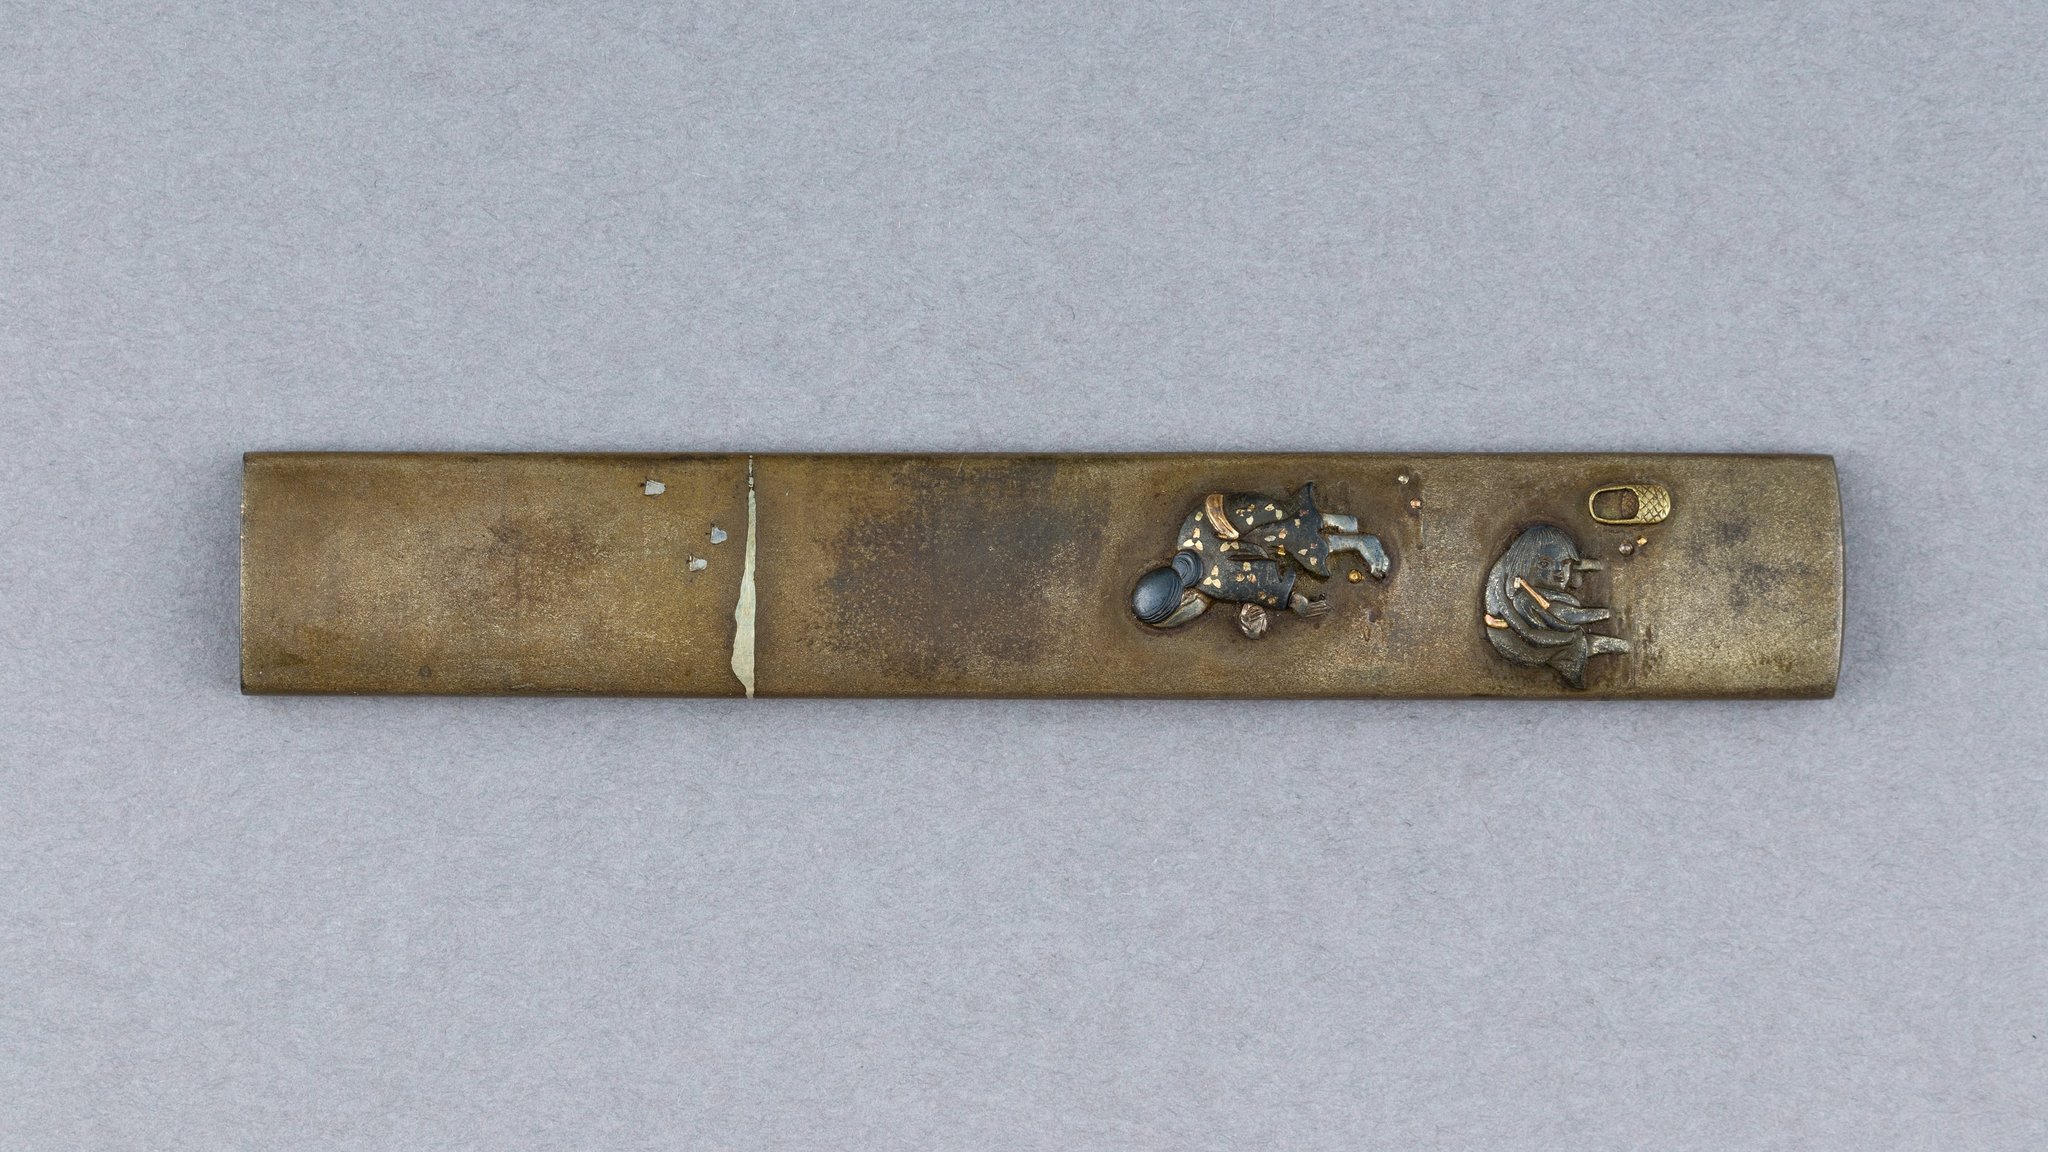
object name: knife handle kozuka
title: Knife Handle (Kozuka)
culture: japanese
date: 1615-1868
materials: gold alloy, silver alloy, gold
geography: japan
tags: women